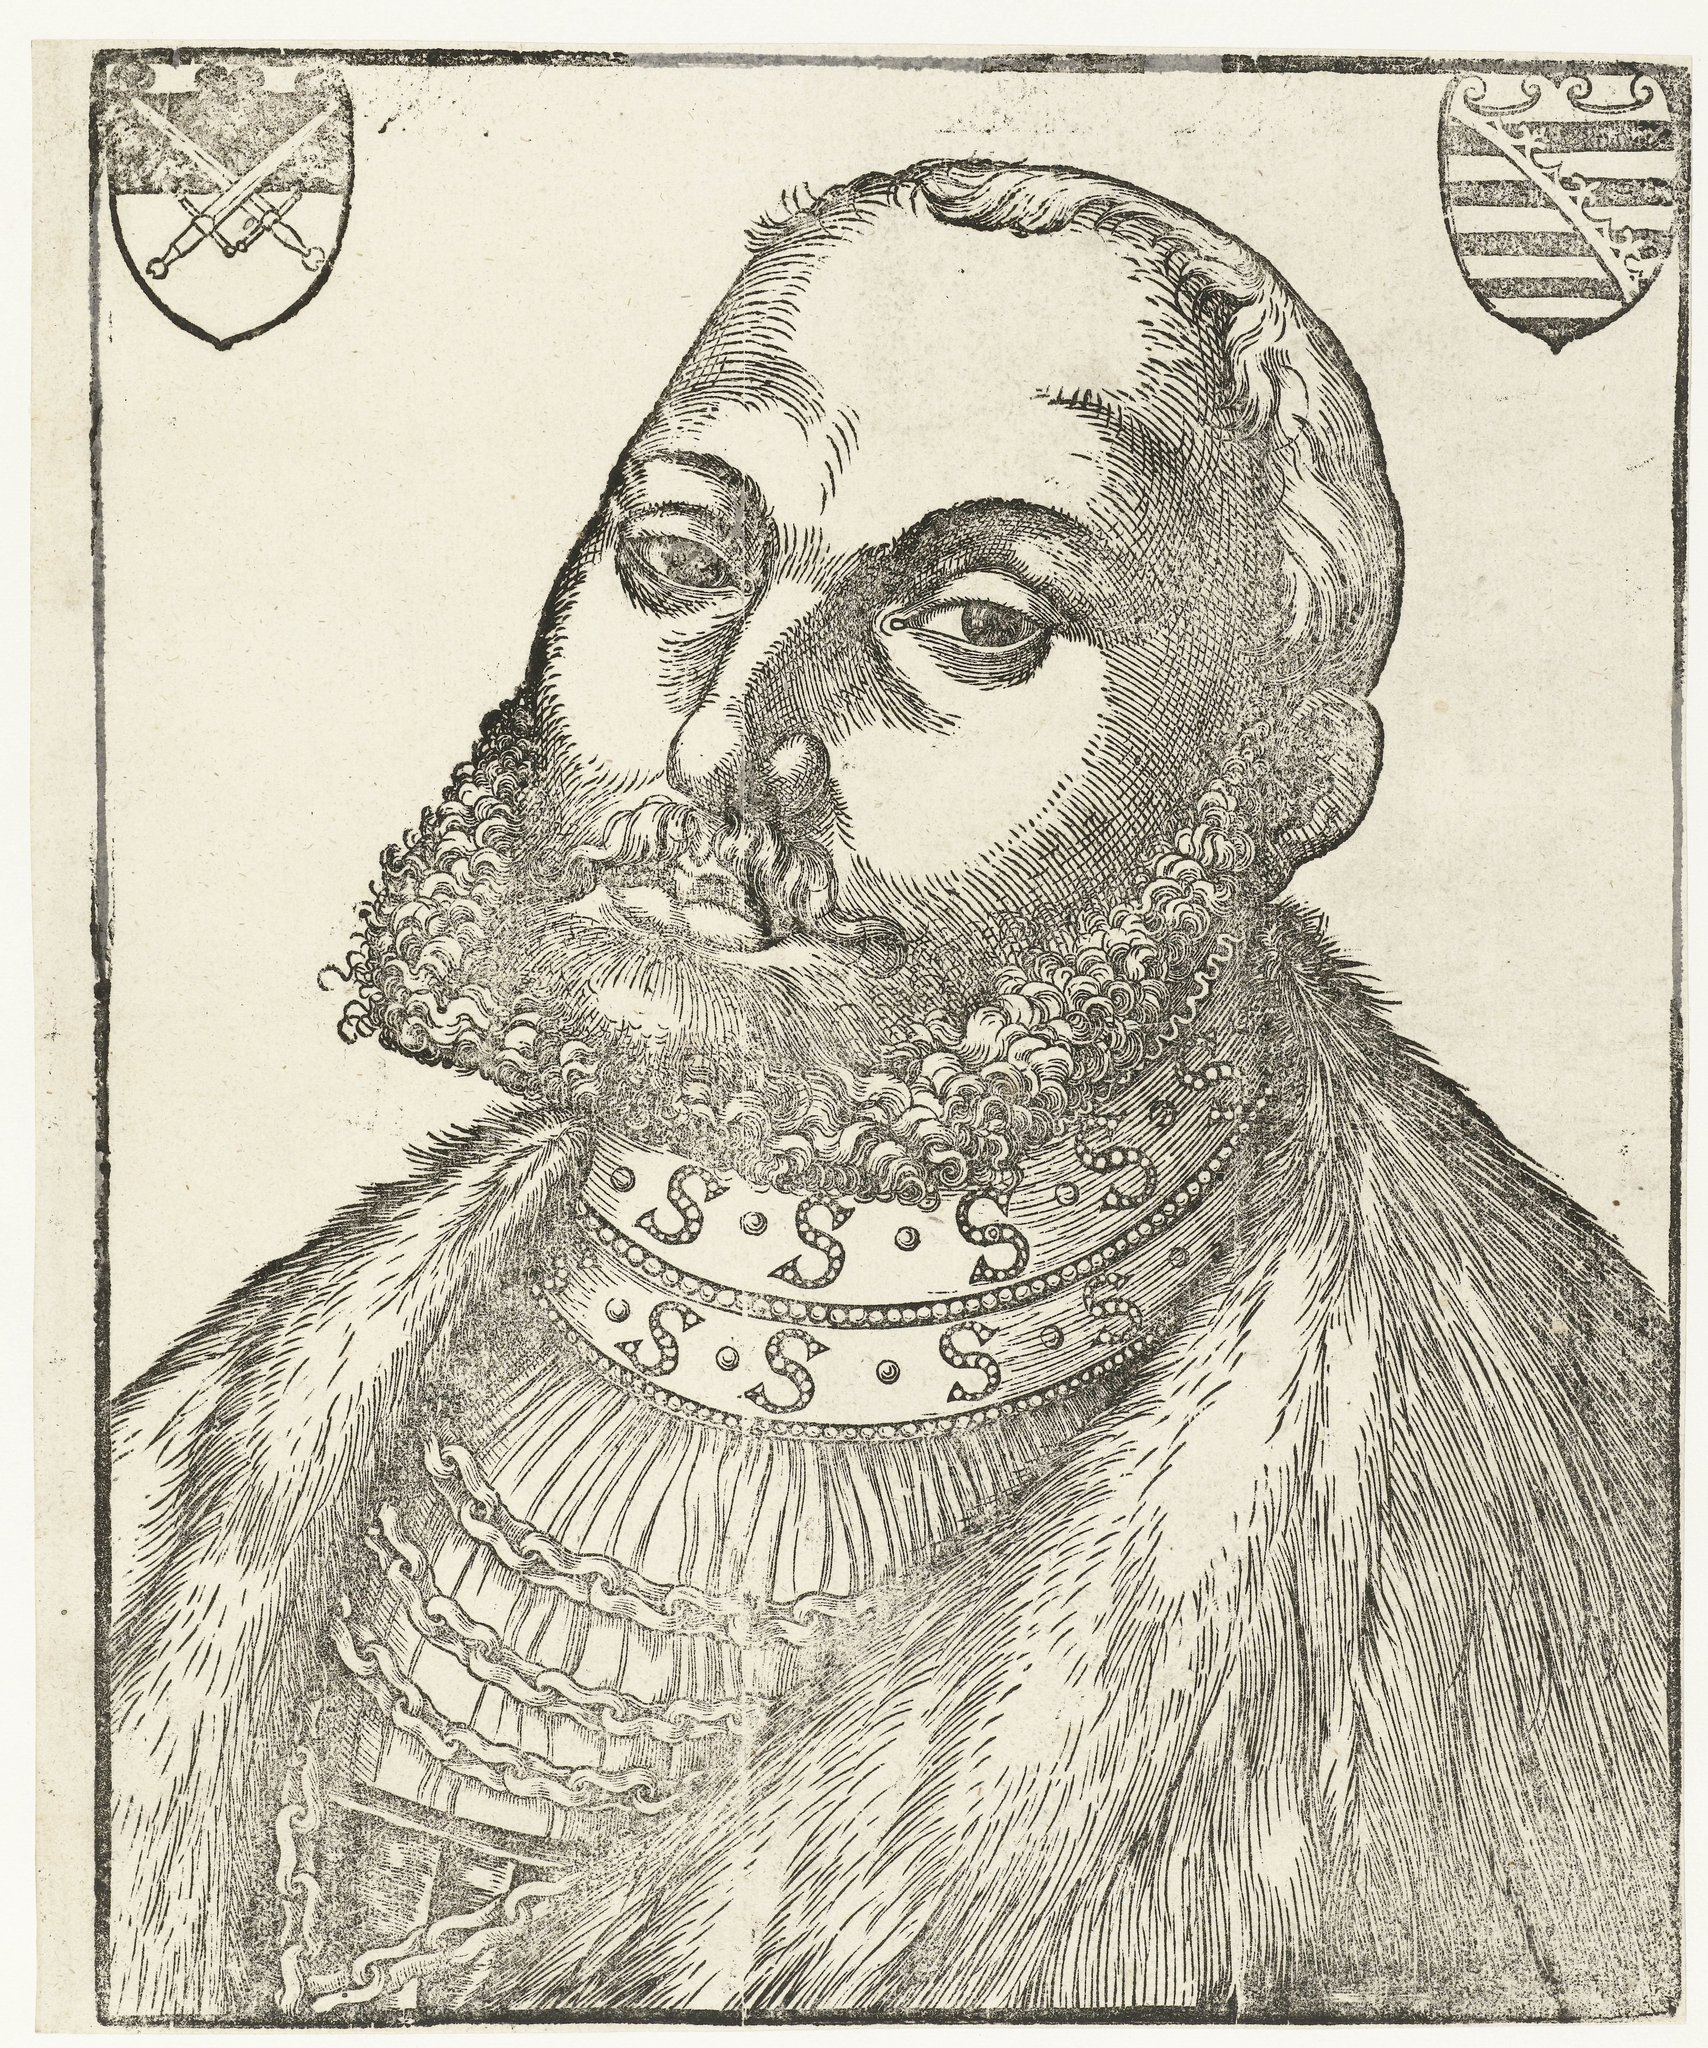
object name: print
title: Portret van Johan Frederik I (Johan Frederik de Grootmoedige) hertog van Saksen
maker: lucas cranach (i)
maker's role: draughtsman, print maker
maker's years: 1472-1553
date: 1503-1593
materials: paper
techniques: woodcut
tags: torgau, weimar, keurvorst, johan frederik i (keurvorst van saksen)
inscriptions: collector's mark: Lugt 240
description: Portret van Johan Frederik I (Johan Frederik de Grootmoedige) hertog van Saksen, gekleed in bontmantel. De kraag van zijn kleding is versierd met een S monogram dat verwijst naar Saksen. Links- en rechtsboven zijn de schilden met het keurvorstelijk en hertogelijk wapen van Saksen weergegeven.